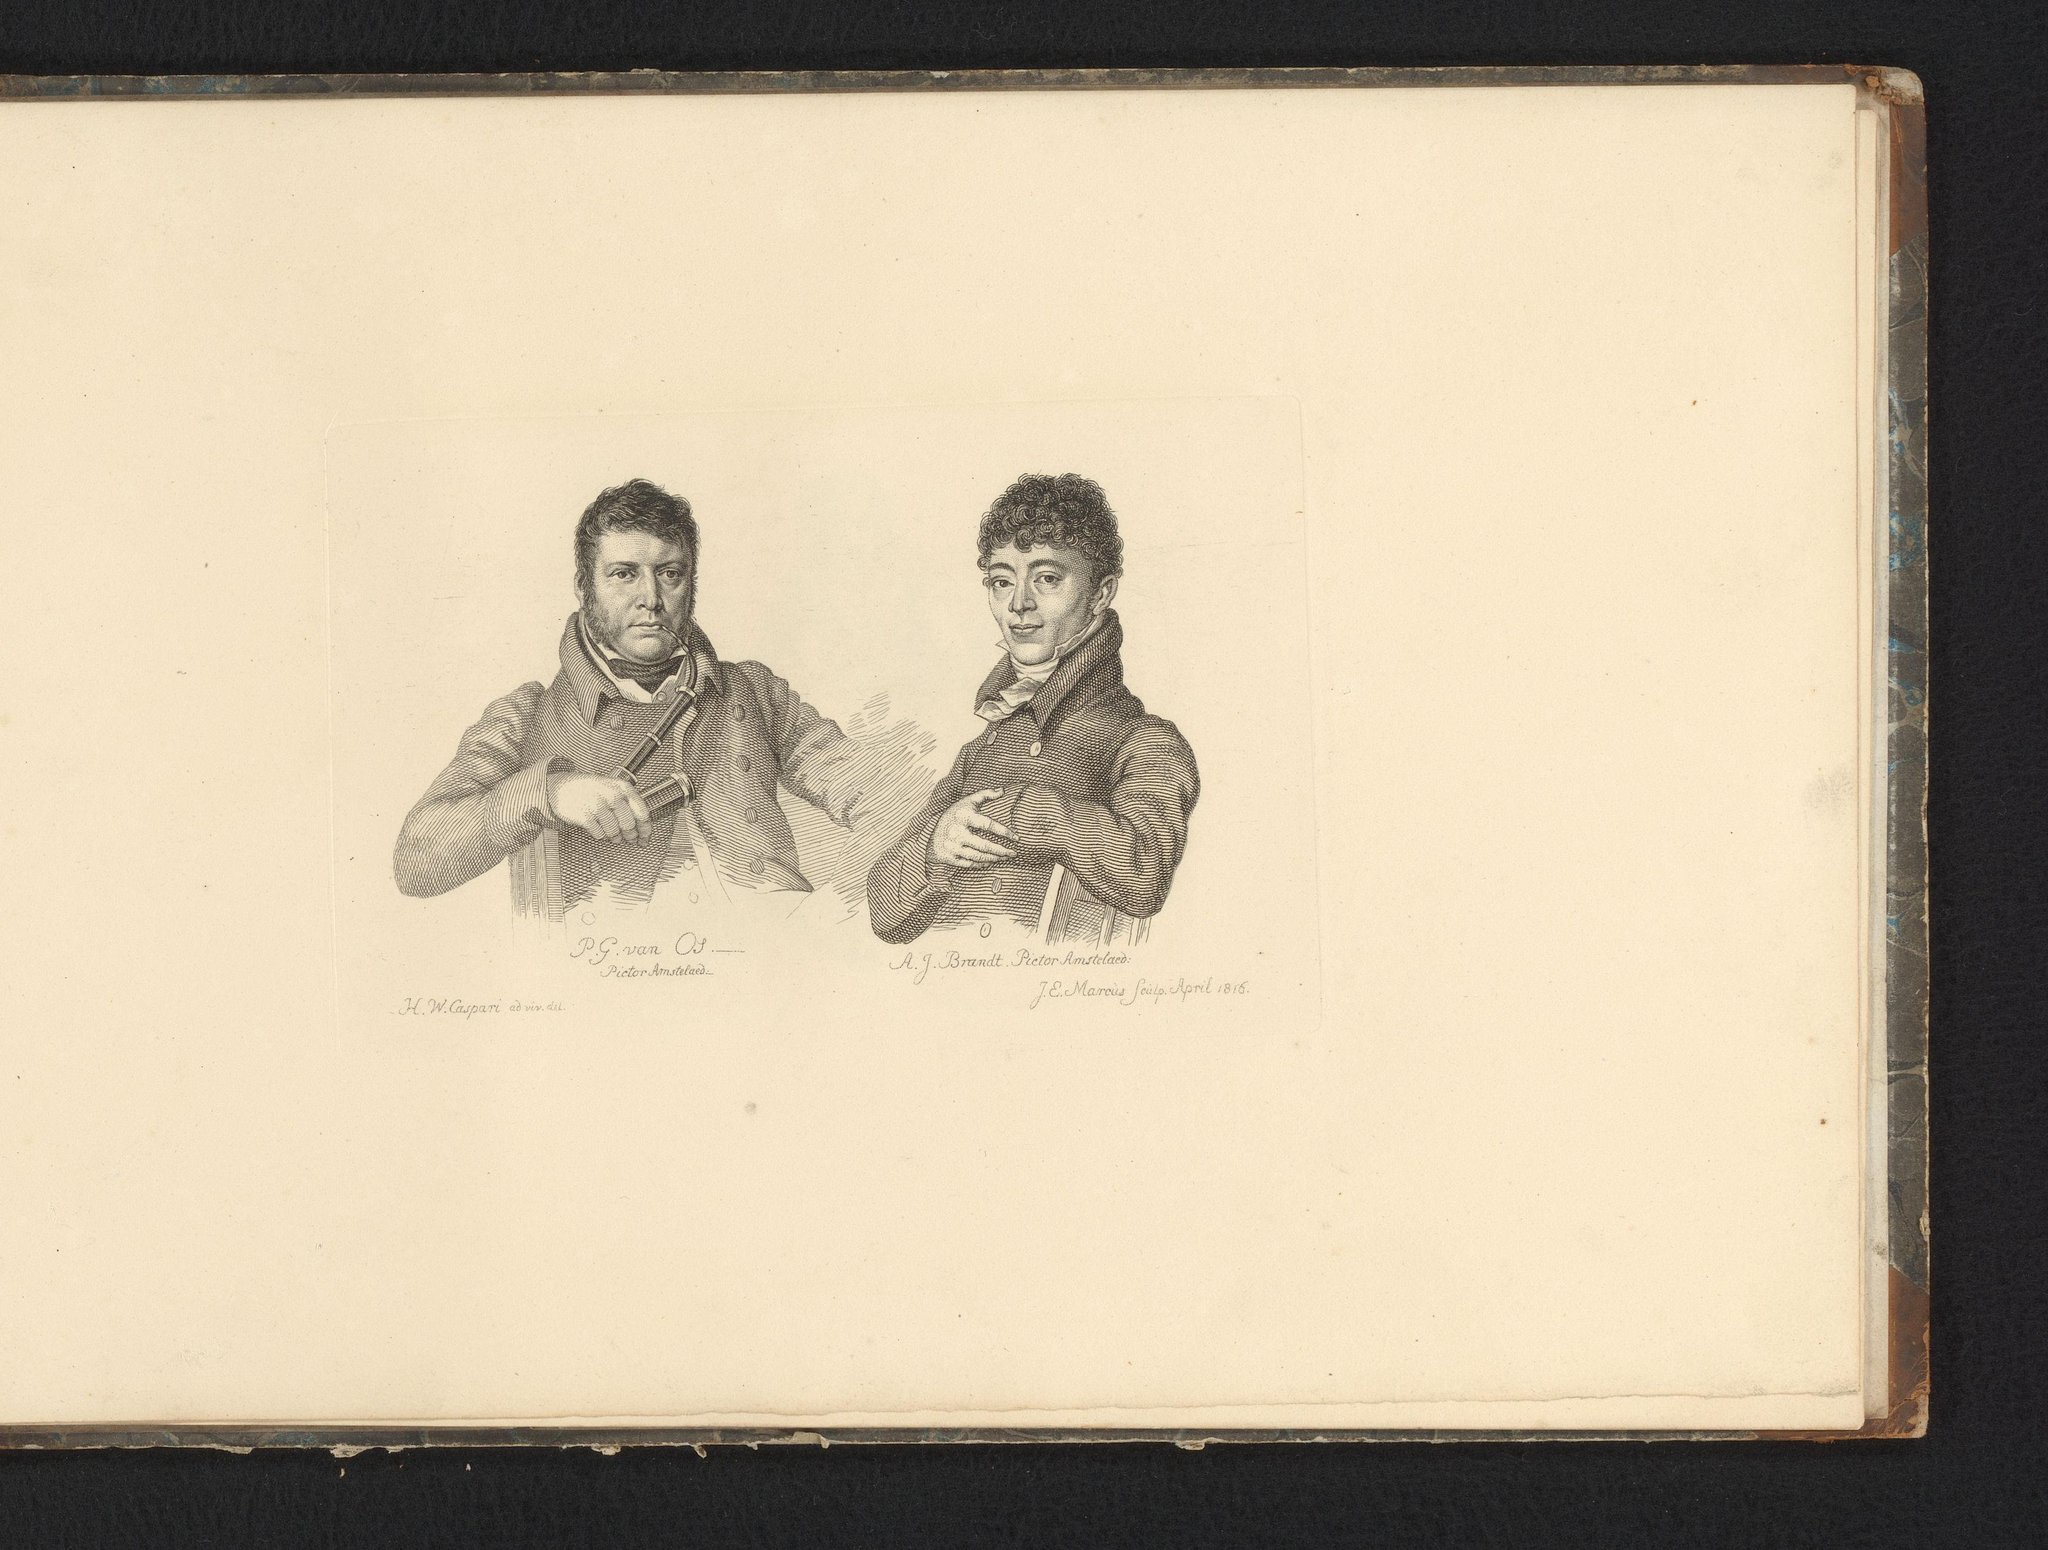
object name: print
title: Portretten van Pieter Gerardus van Os en Albertus Jonas Brandt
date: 1804-1816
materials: paper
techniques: etching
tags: the hague, painter, print maker, pieter gerardus van os, amsterdam, draughtsman, albertus jonas brandt, historical persons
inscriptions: date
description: Deze prent maakt deel uit van een album.